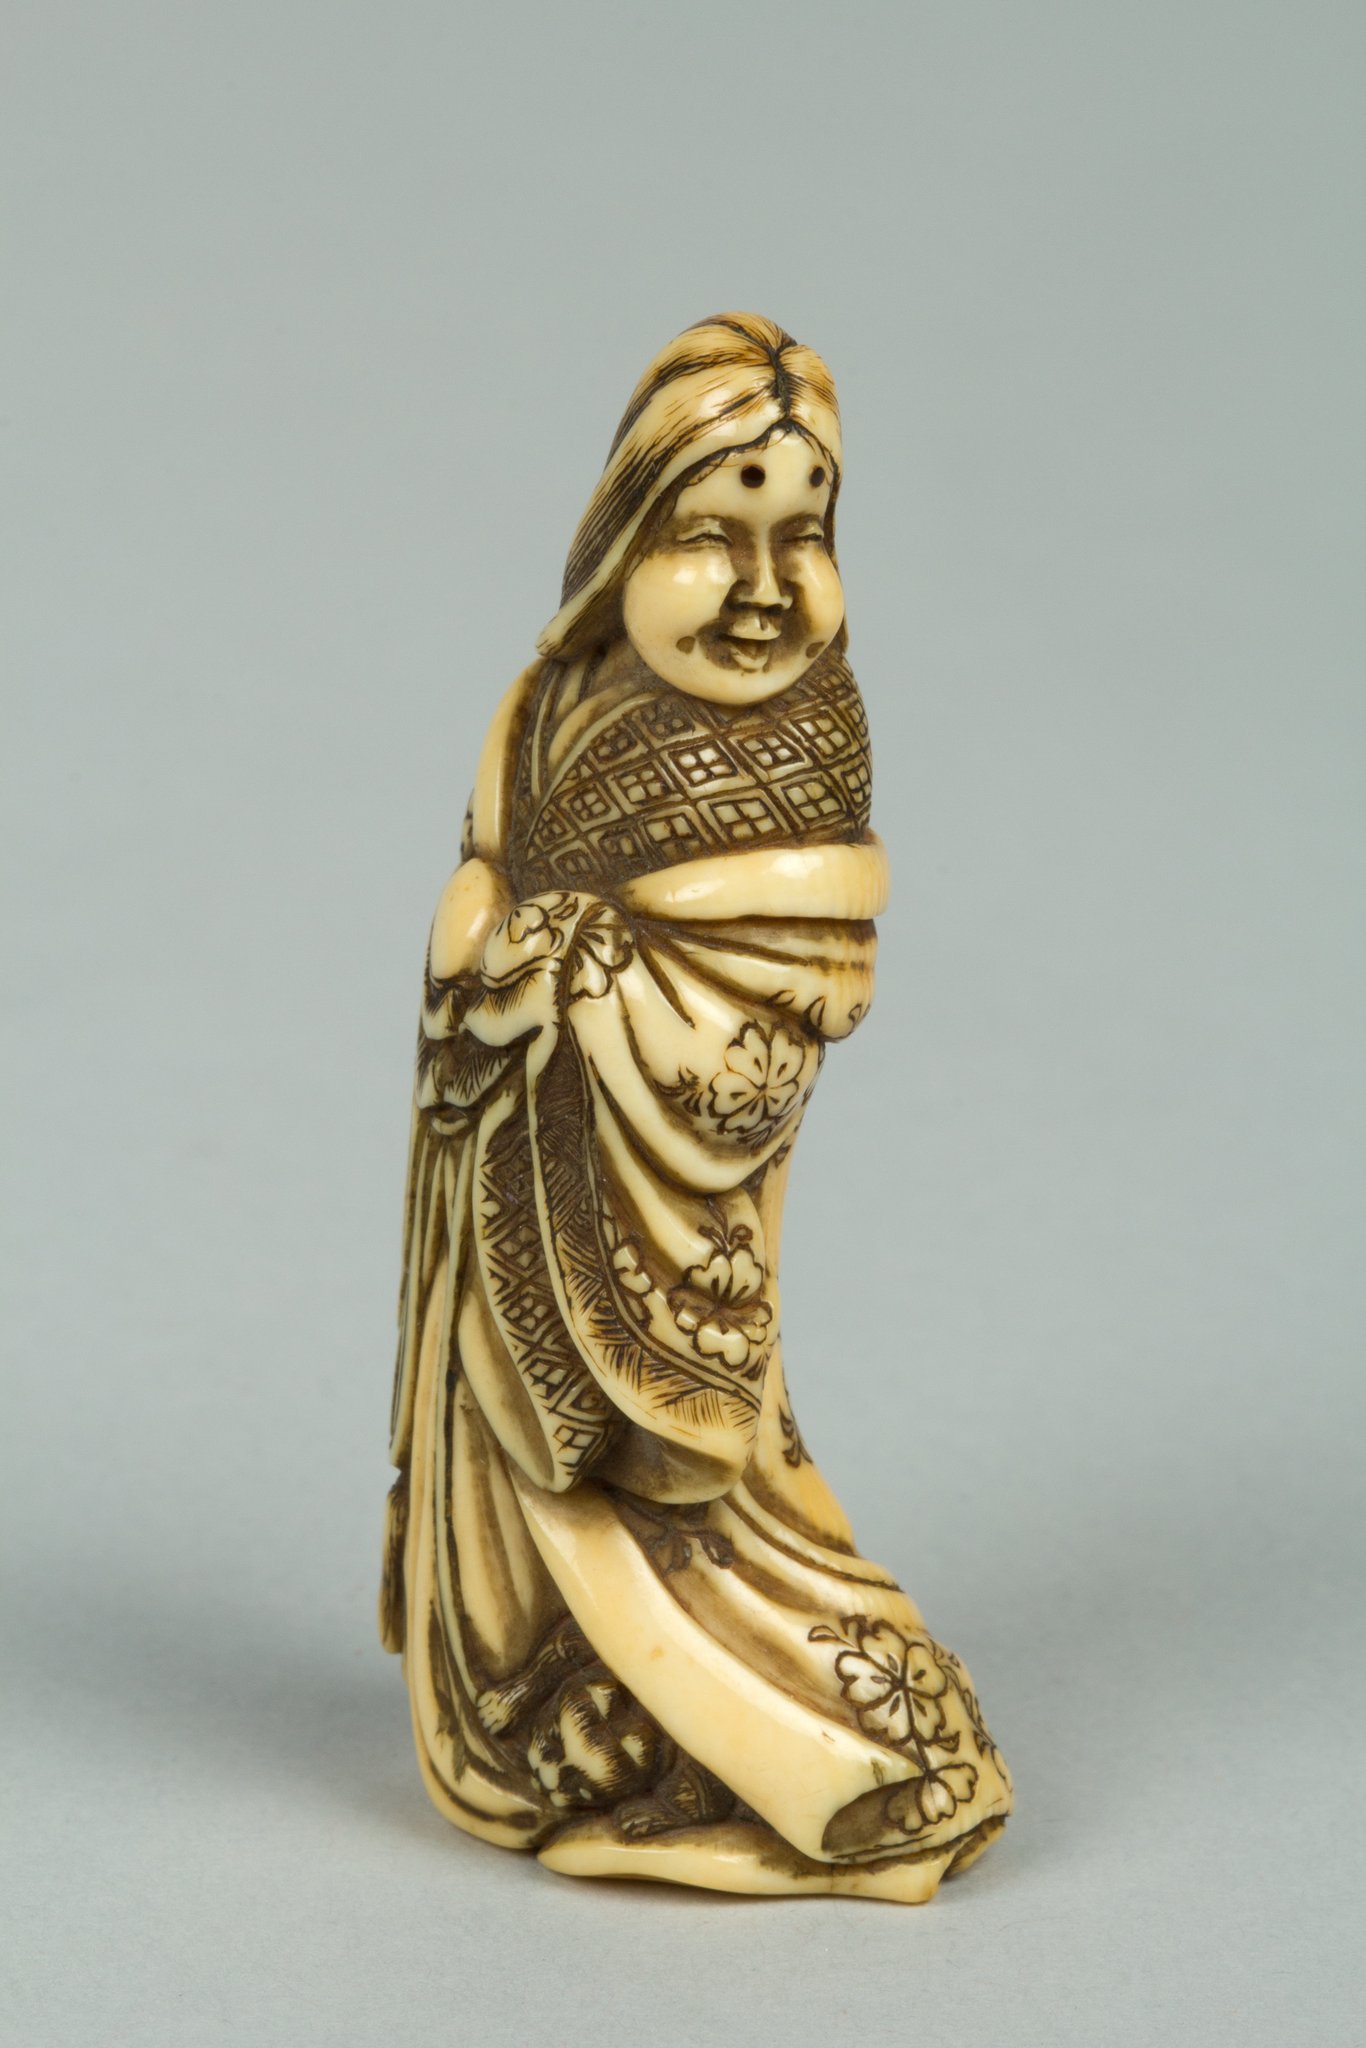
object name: netsuke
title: Netsuke of a Woman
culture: japanese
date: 1801-1900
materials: ivory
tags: women